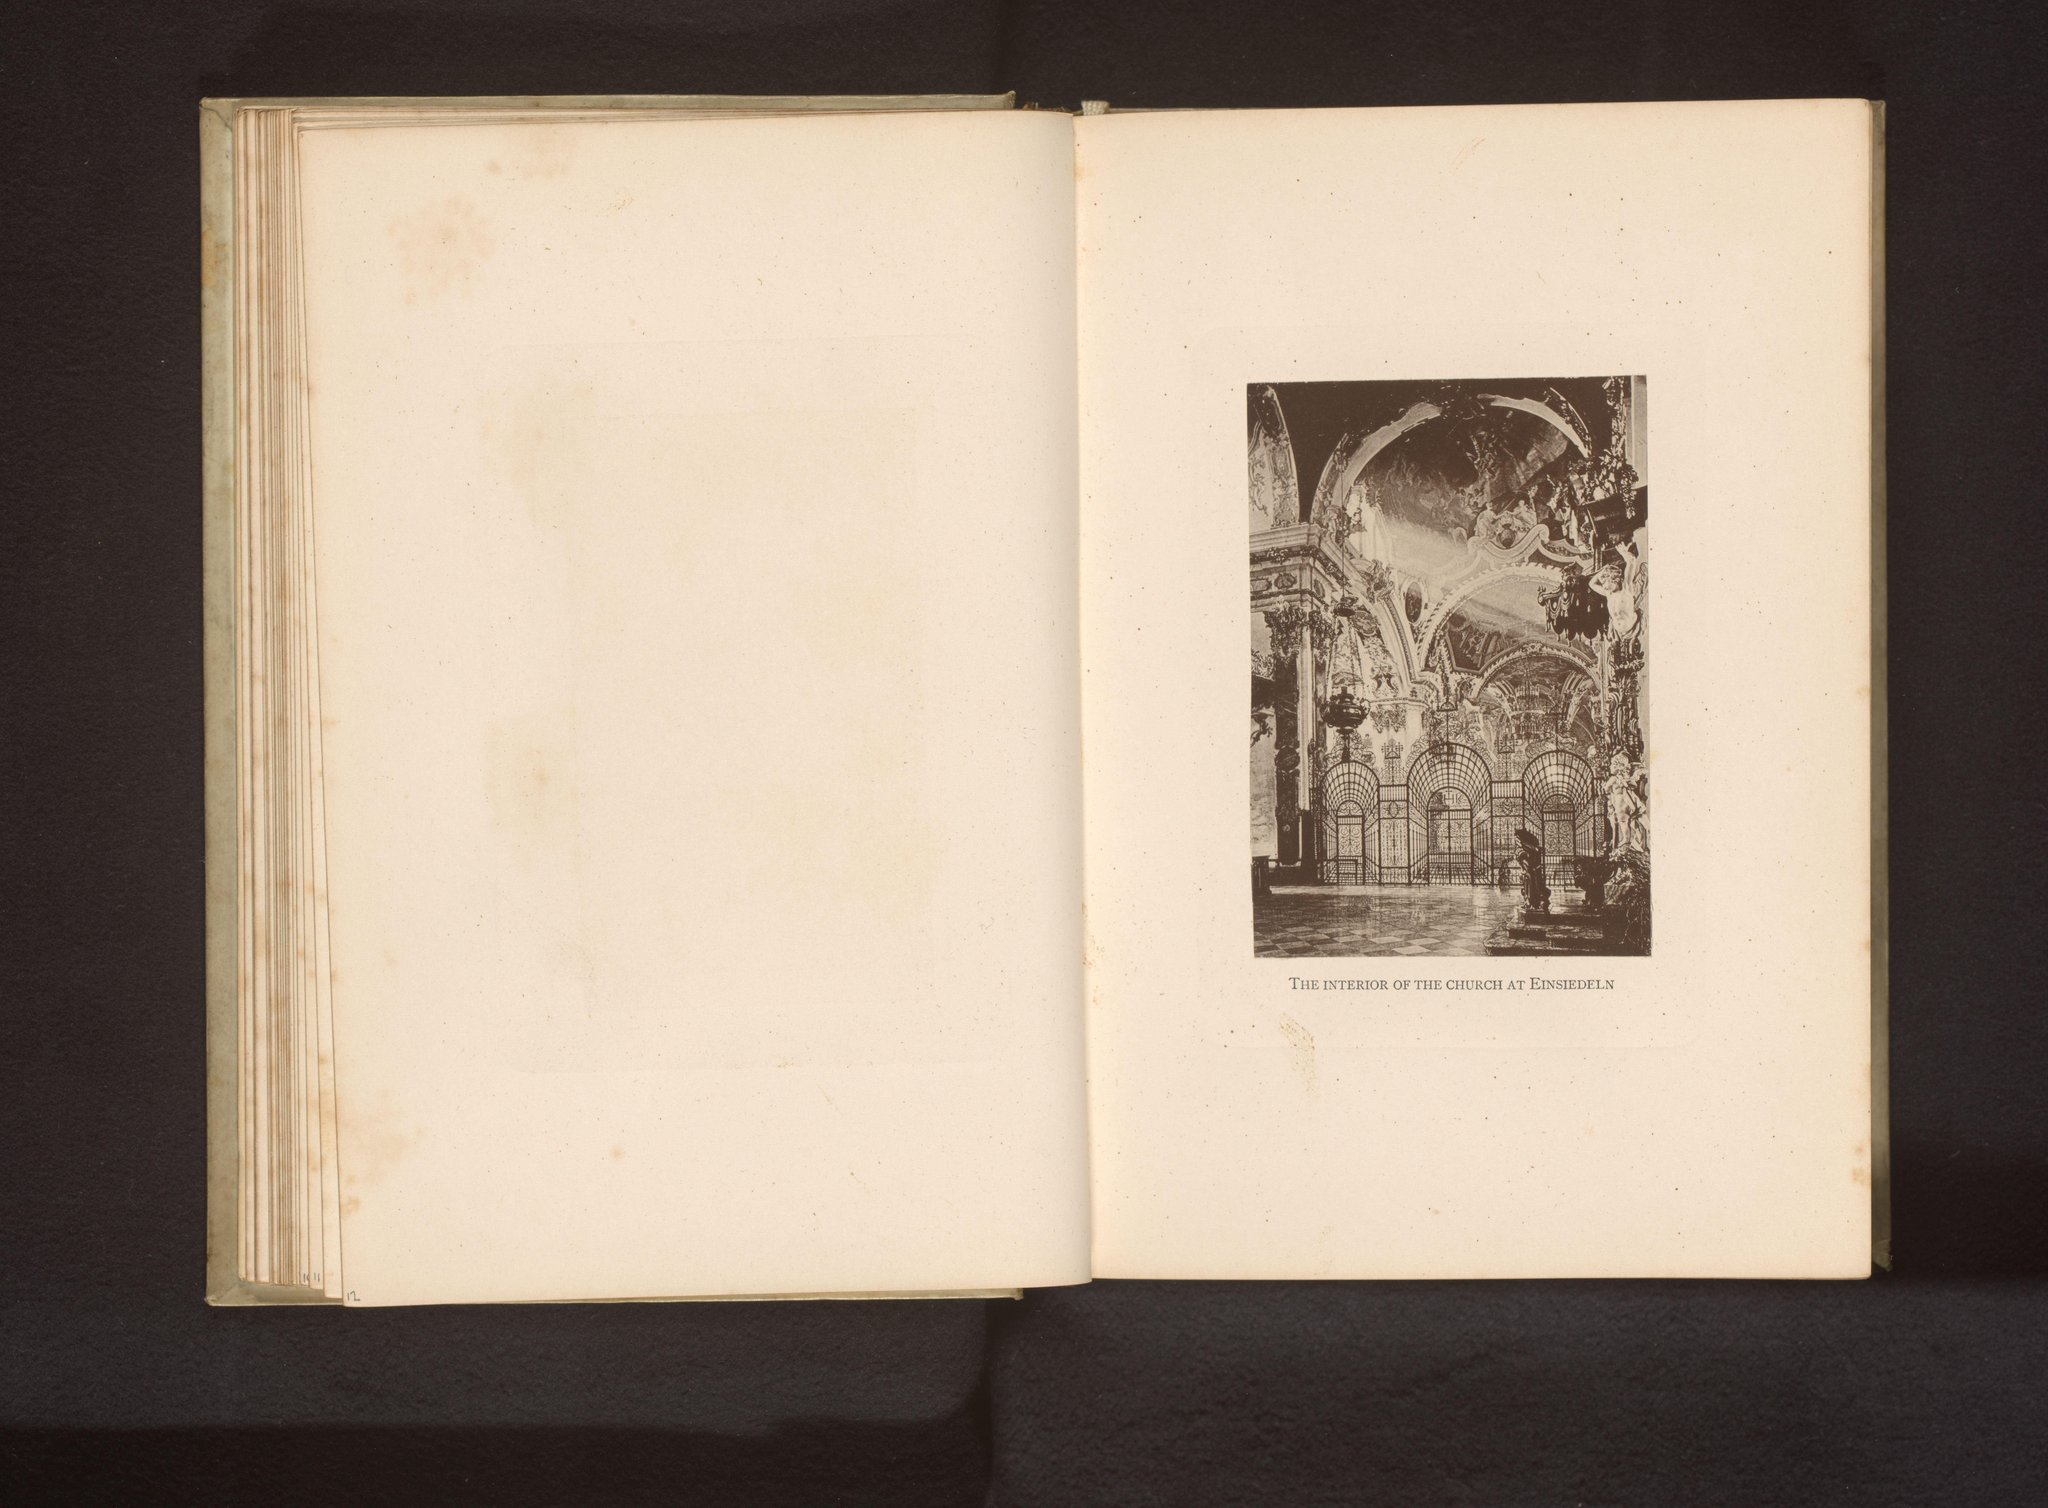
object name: photomechanical print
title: The interior of the church of Einsiedeln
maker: Anonymous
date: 1874-1884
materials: paper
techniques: photograph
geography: einsiedeln abbey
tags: interior of church